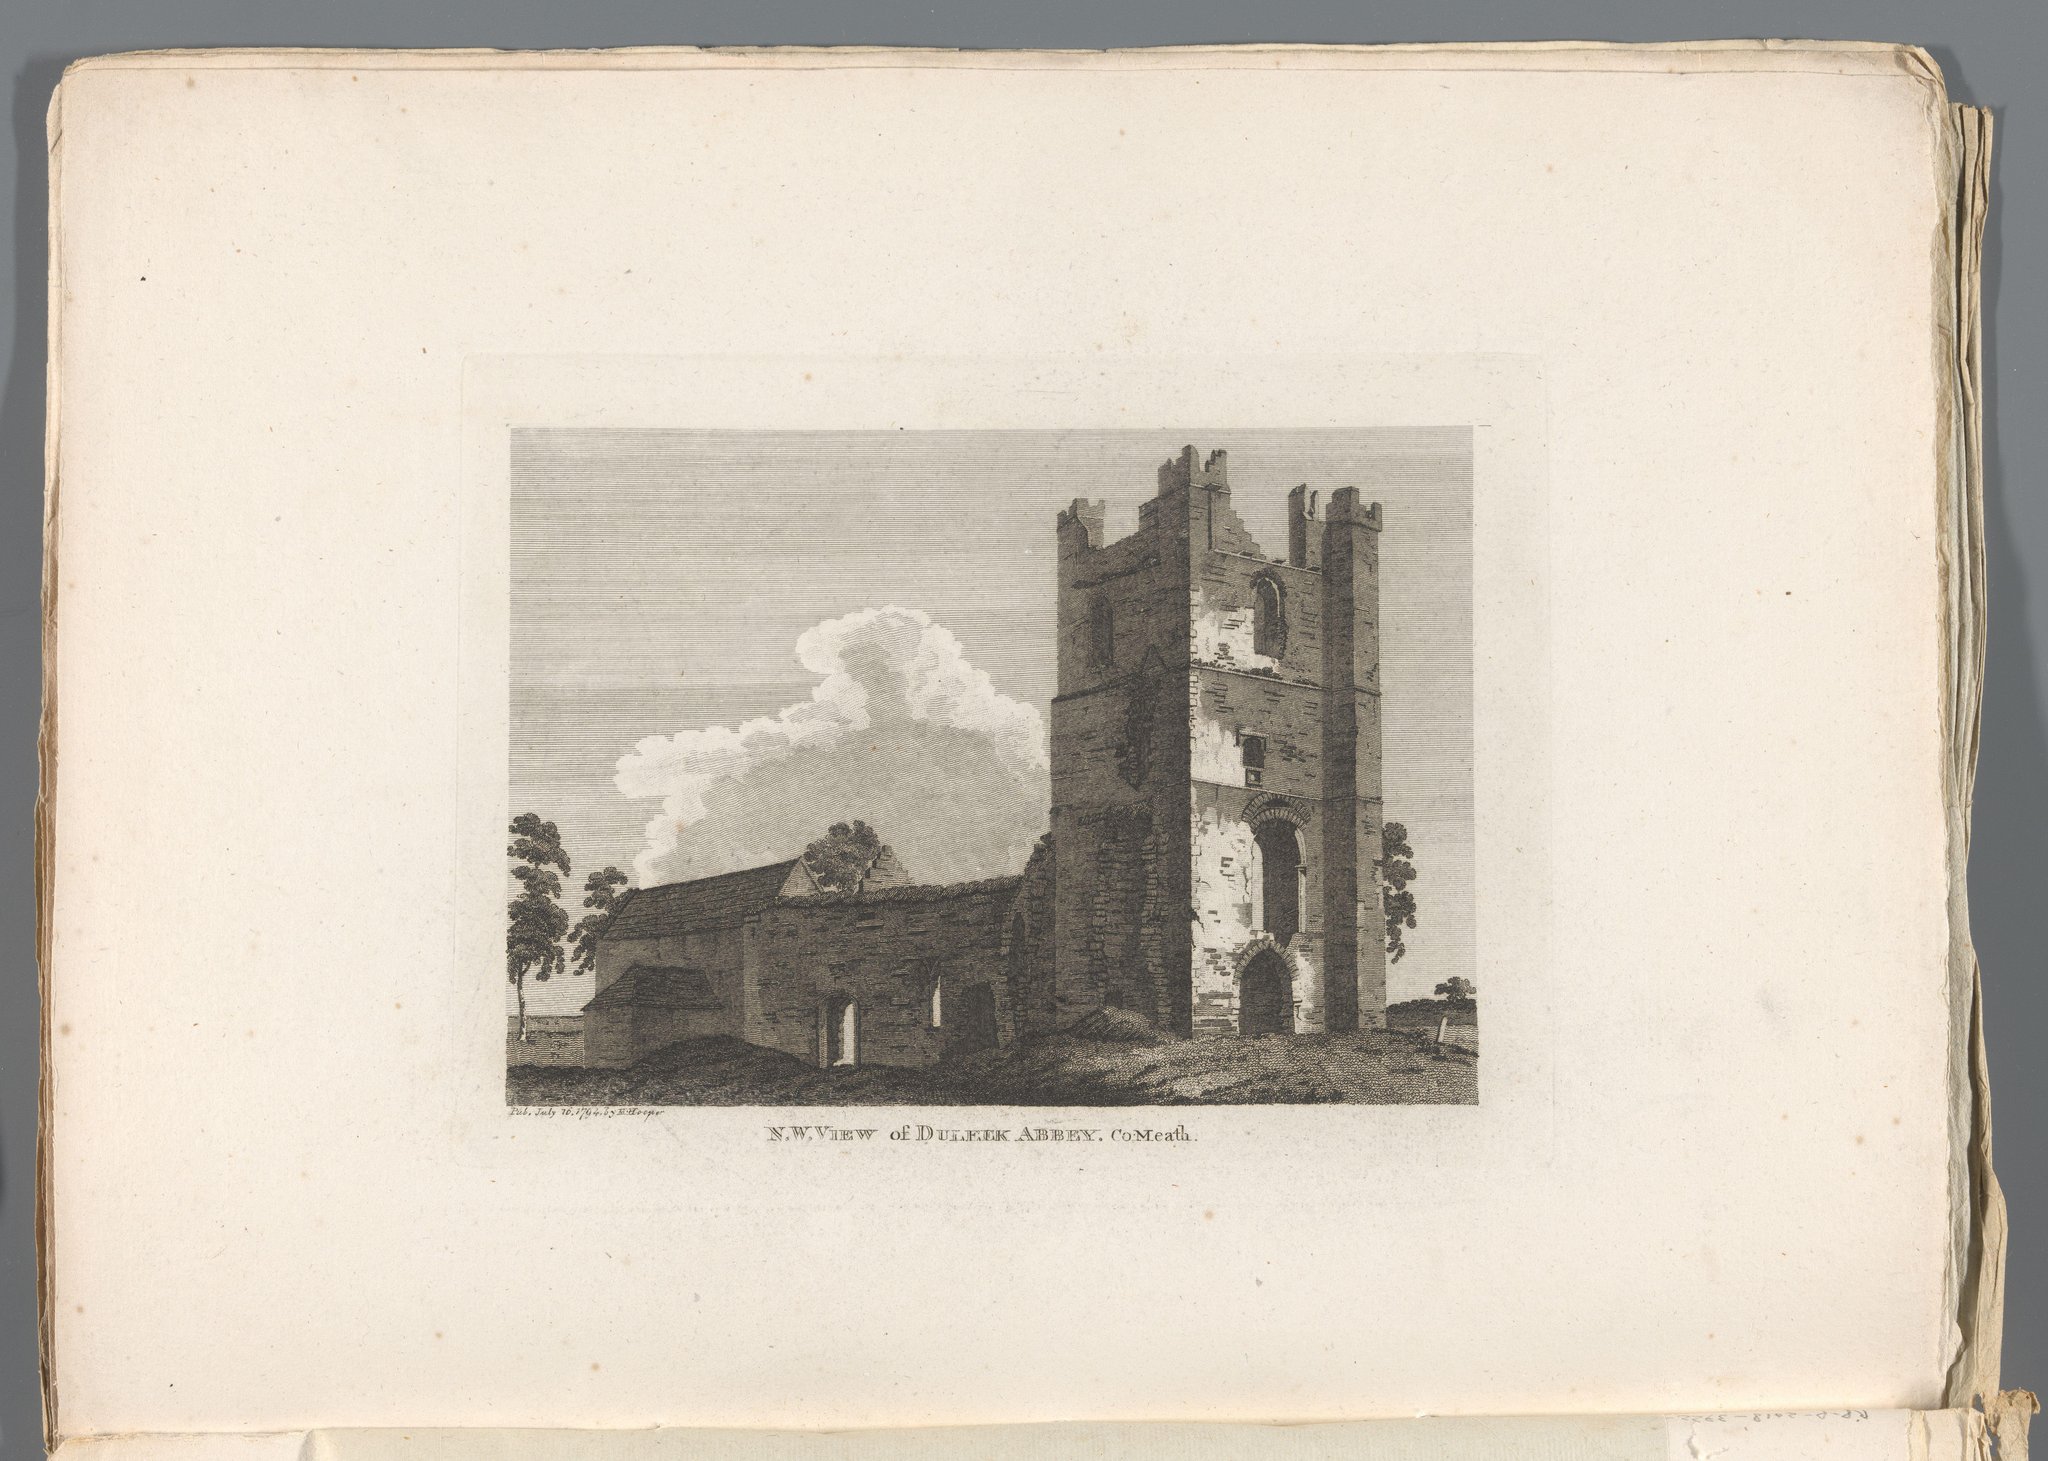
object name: book illustration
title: N.W.View of Duleek Abbey. Co.Meath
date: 1794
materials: paper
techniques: etching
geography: london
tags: abbey, monastery, convent ~ roman catholic church, landscape with ruins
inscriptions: date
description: Prent verschenen in: Grose, Francis. The antiquities of Ireland. Londen: S. Hooper, 1795, dl. 2.